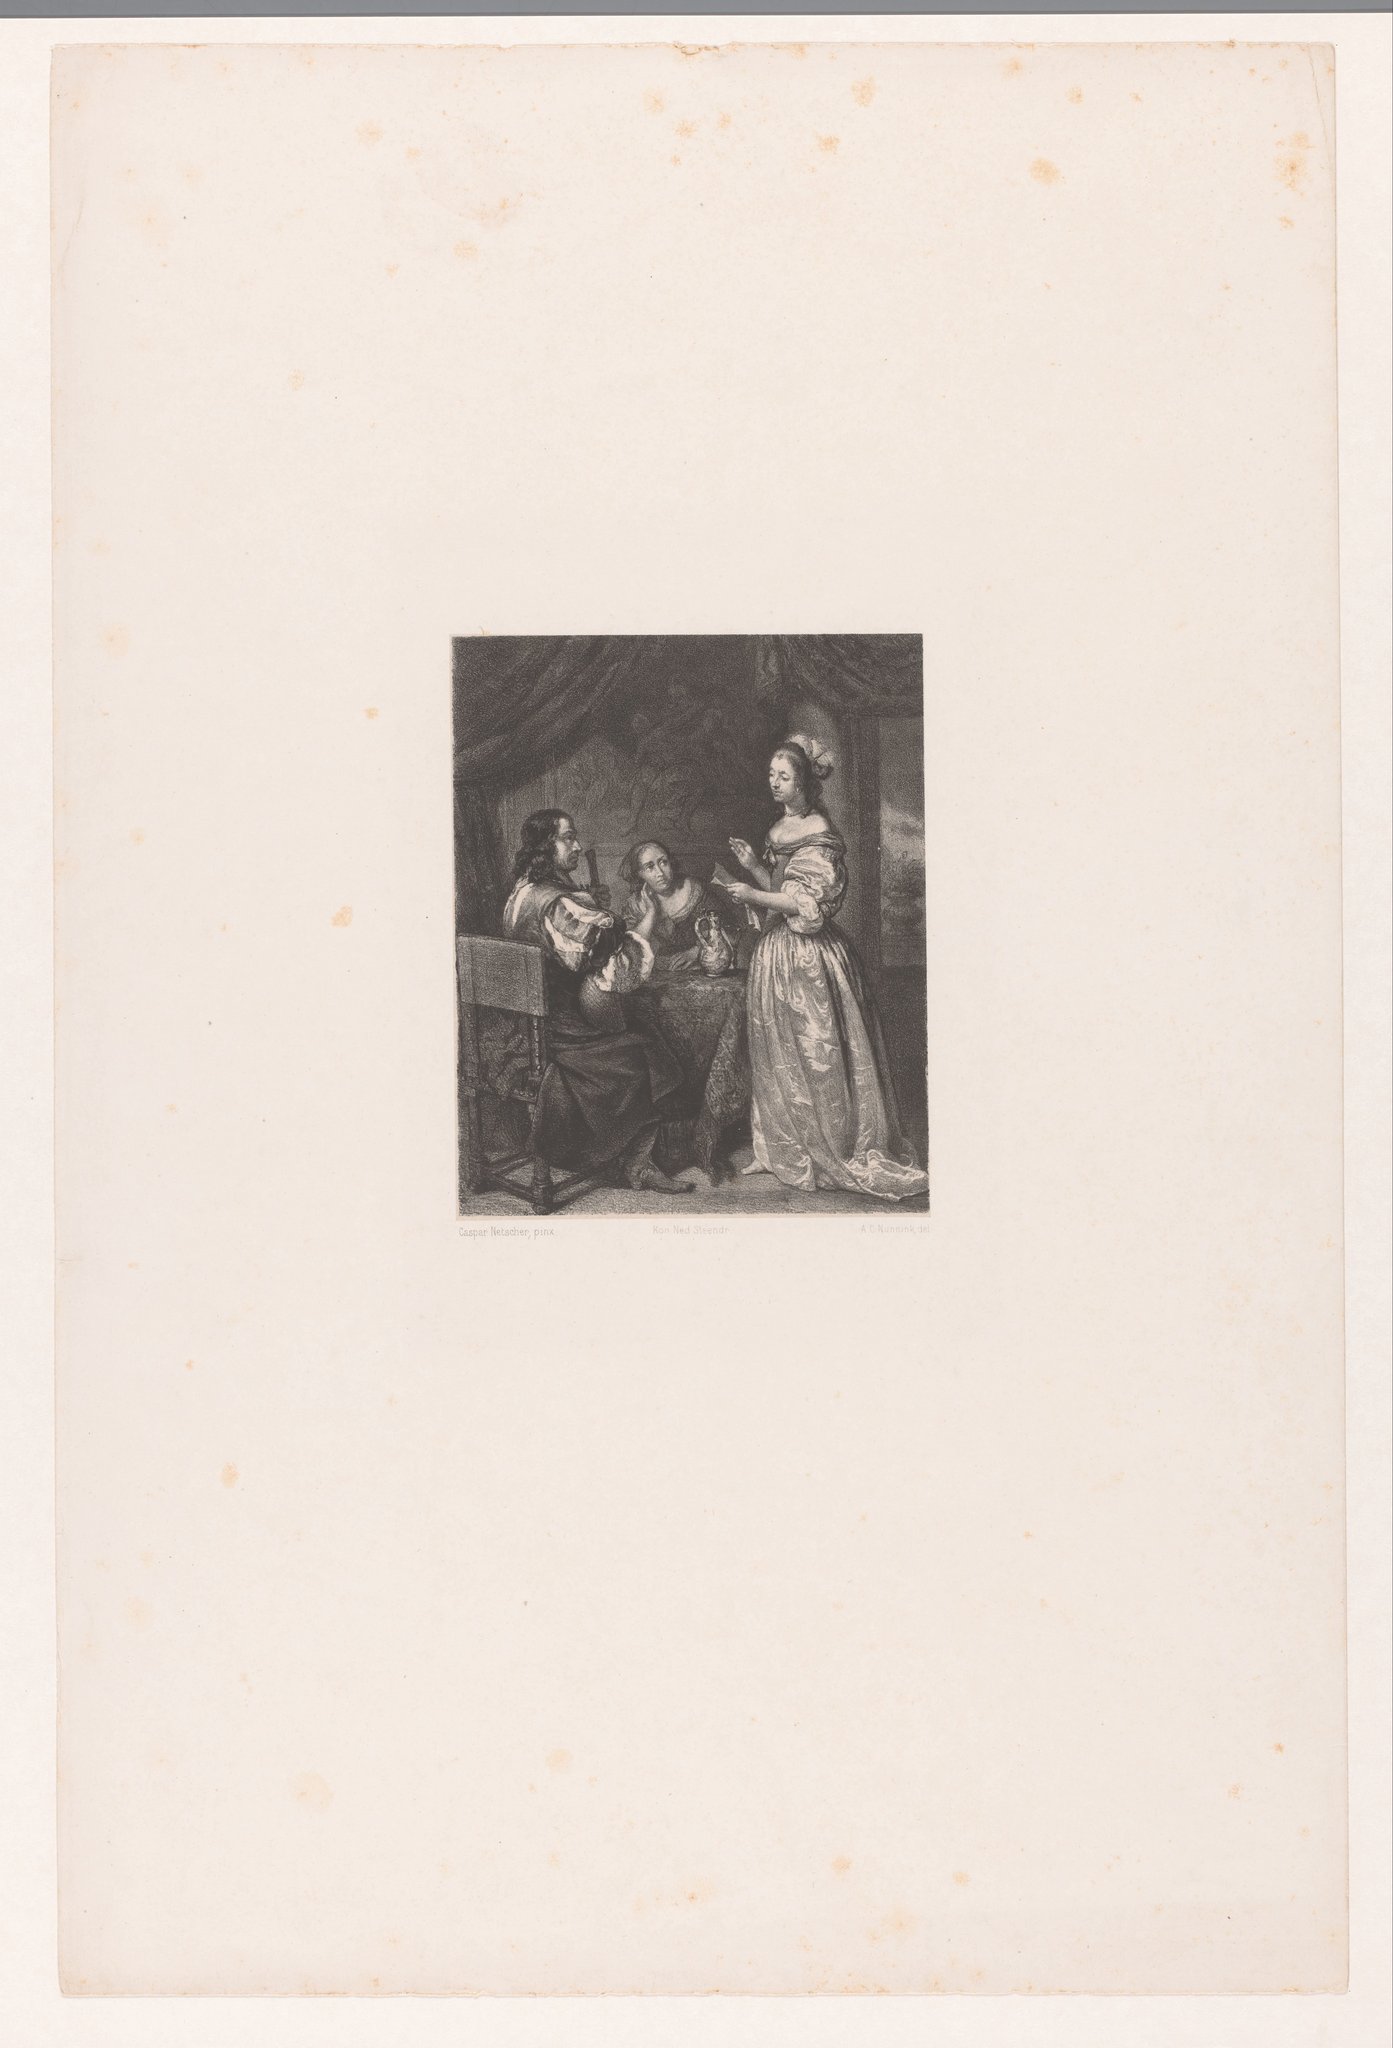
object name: print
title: Muziekmakend gezelschap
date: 1867-1874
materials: paper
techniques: lithograph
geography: the hague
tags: instrumental and vocal music together, cithern, mandolin, guitar, balalaika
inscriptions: collector's mark: Lugt 2228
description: Een man begeleidt de zingende vrouw naast hem op zijn mandoline. Een vrouw aan tafel luistert neer de muzikanten.